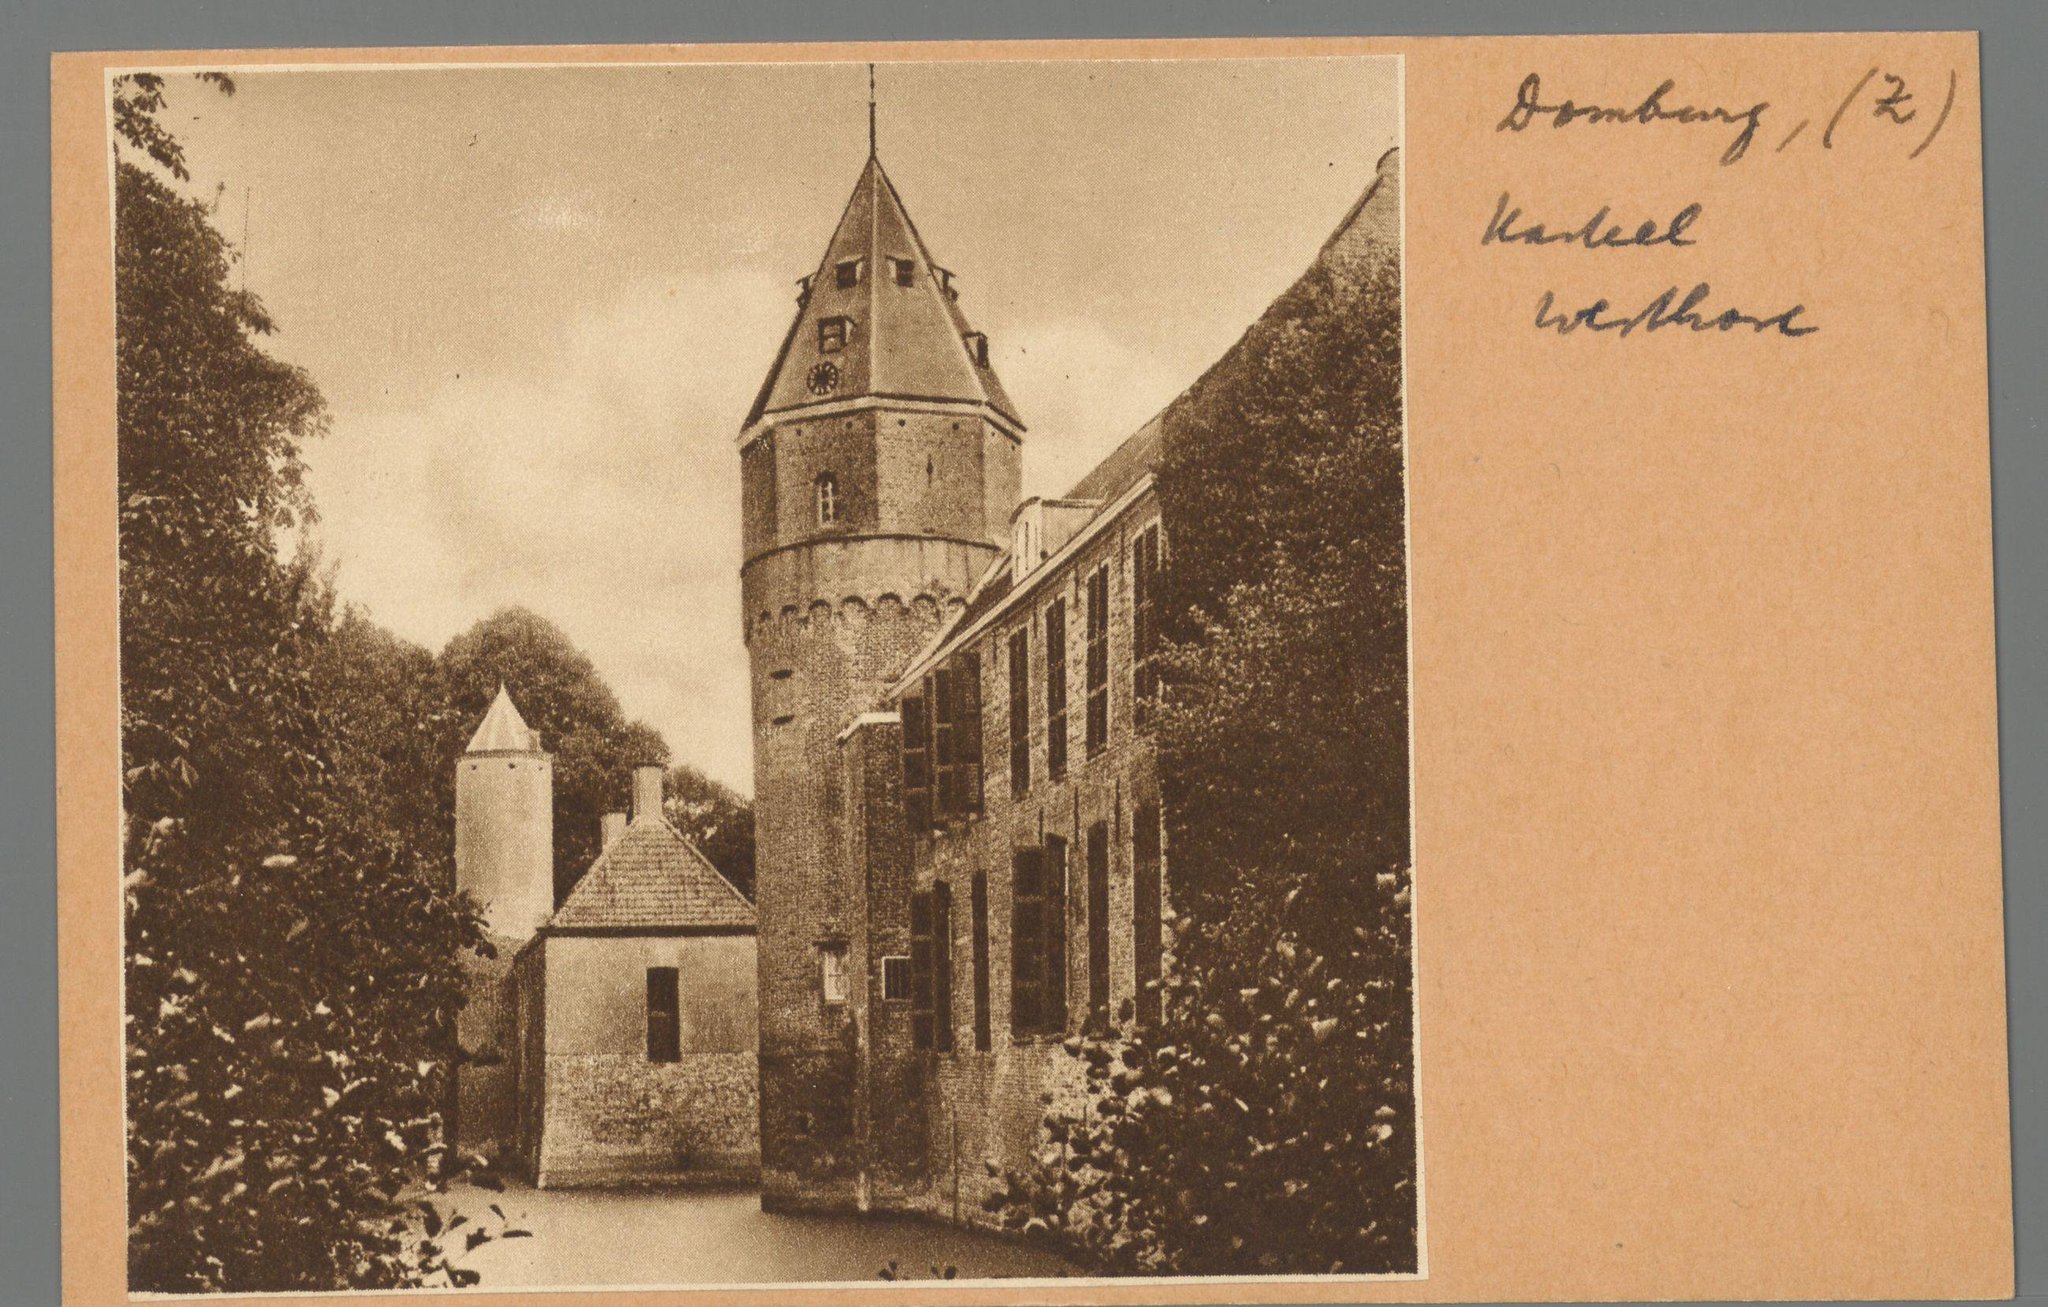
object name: ansichtkaart, prentbriefkaart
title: Domburg, (Z). Kasteel Westhove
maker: Anonymous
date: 1895-1930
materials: cardboard, paper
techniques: rotogravure, writing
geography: oostkapelle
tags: castle, canal